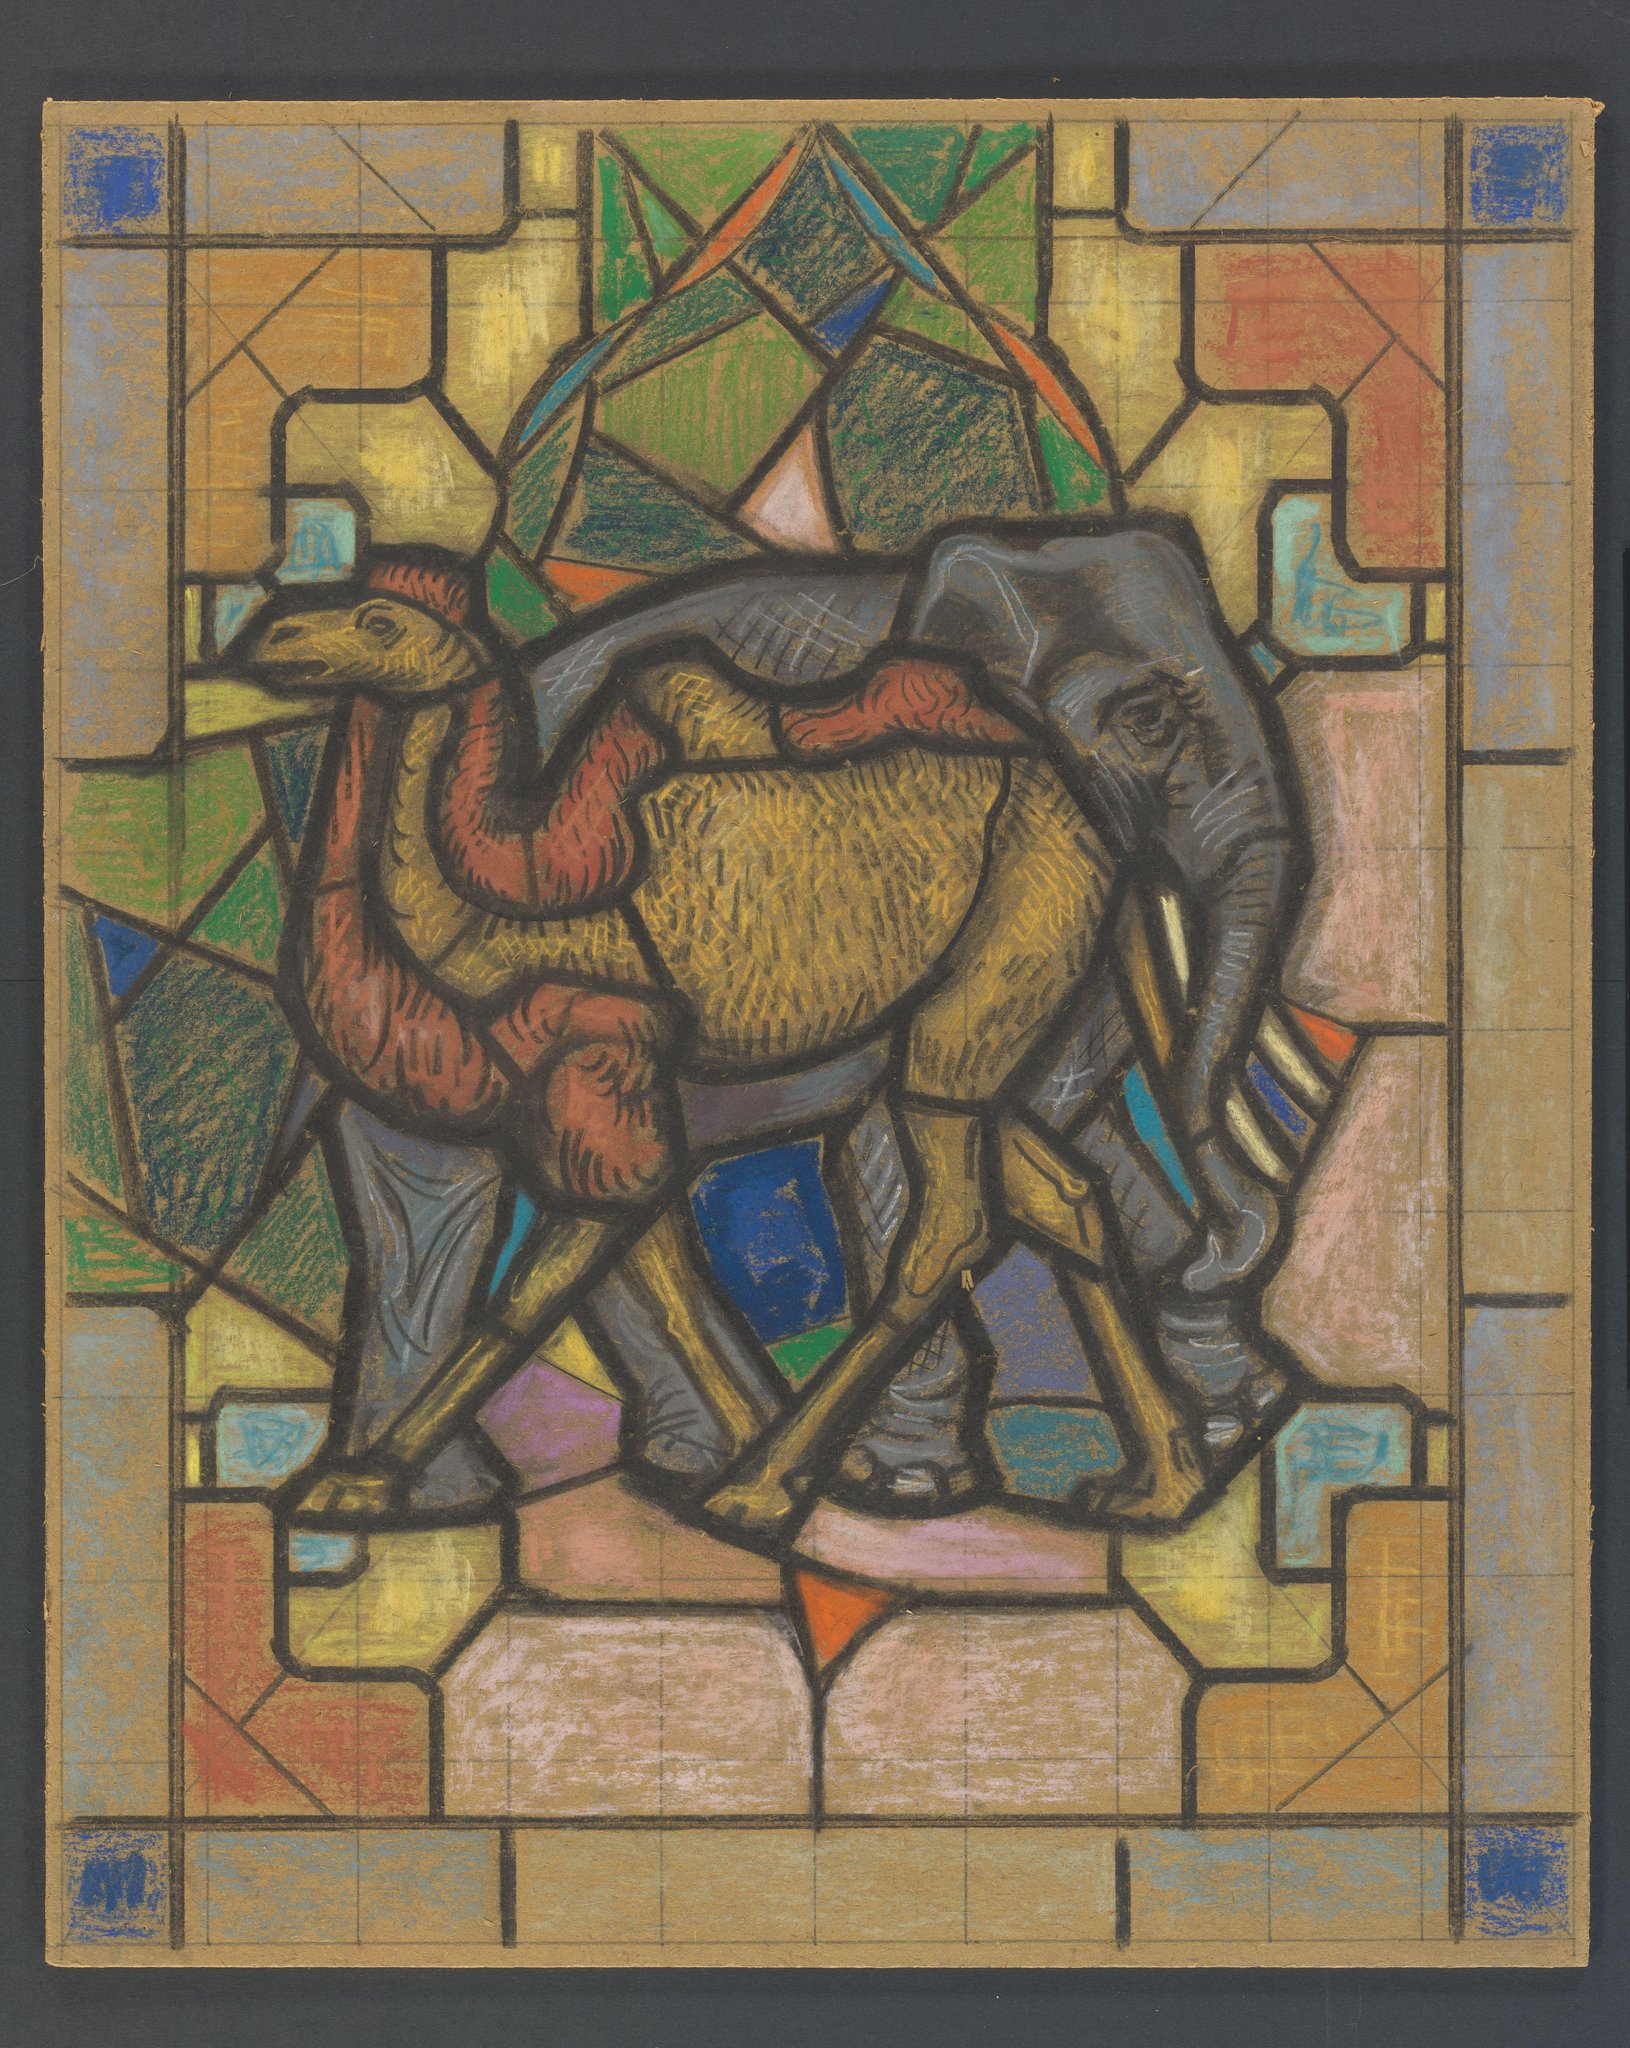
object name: drawing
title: Ontwerp voor een glas in loodraam met een kameel en olifant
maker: jaap weyand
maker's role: draughtsman, painter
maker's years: 1886-1960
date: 1896-1934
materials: cardboard, pastel, pencil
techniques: drawing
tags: hoofed animals: camel, trunked animals: elephant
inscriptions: number: ‘7’